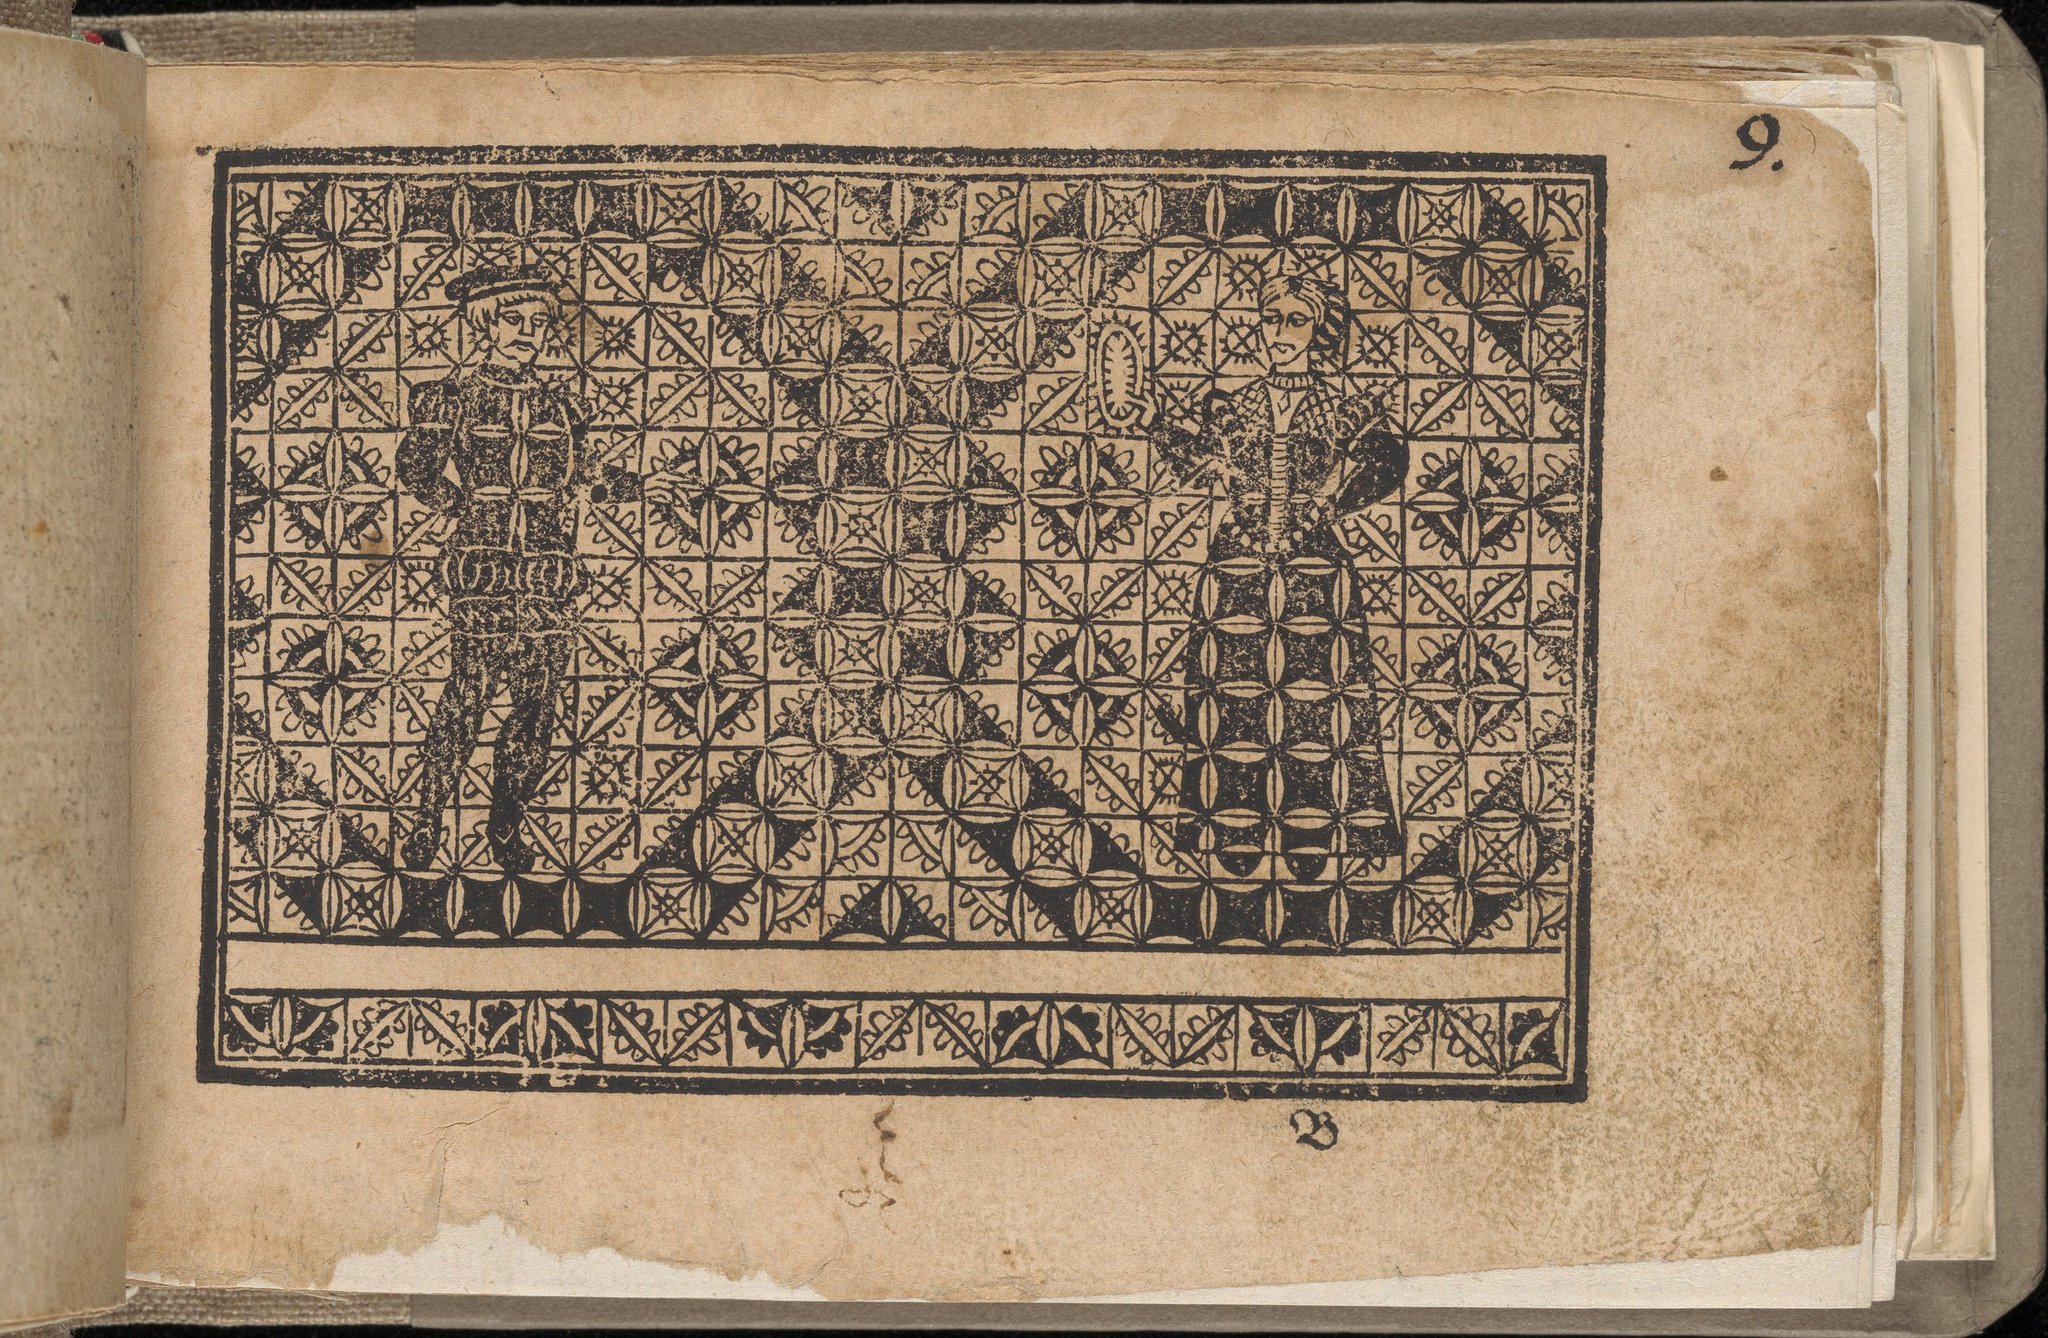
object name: book print ornament architecture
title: Schön newes Modelbuch (Page 9r)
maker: sigismundus latomus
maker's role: publisher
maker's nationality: german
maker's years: 1599-1632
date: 1608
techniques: woodcut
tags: men,women